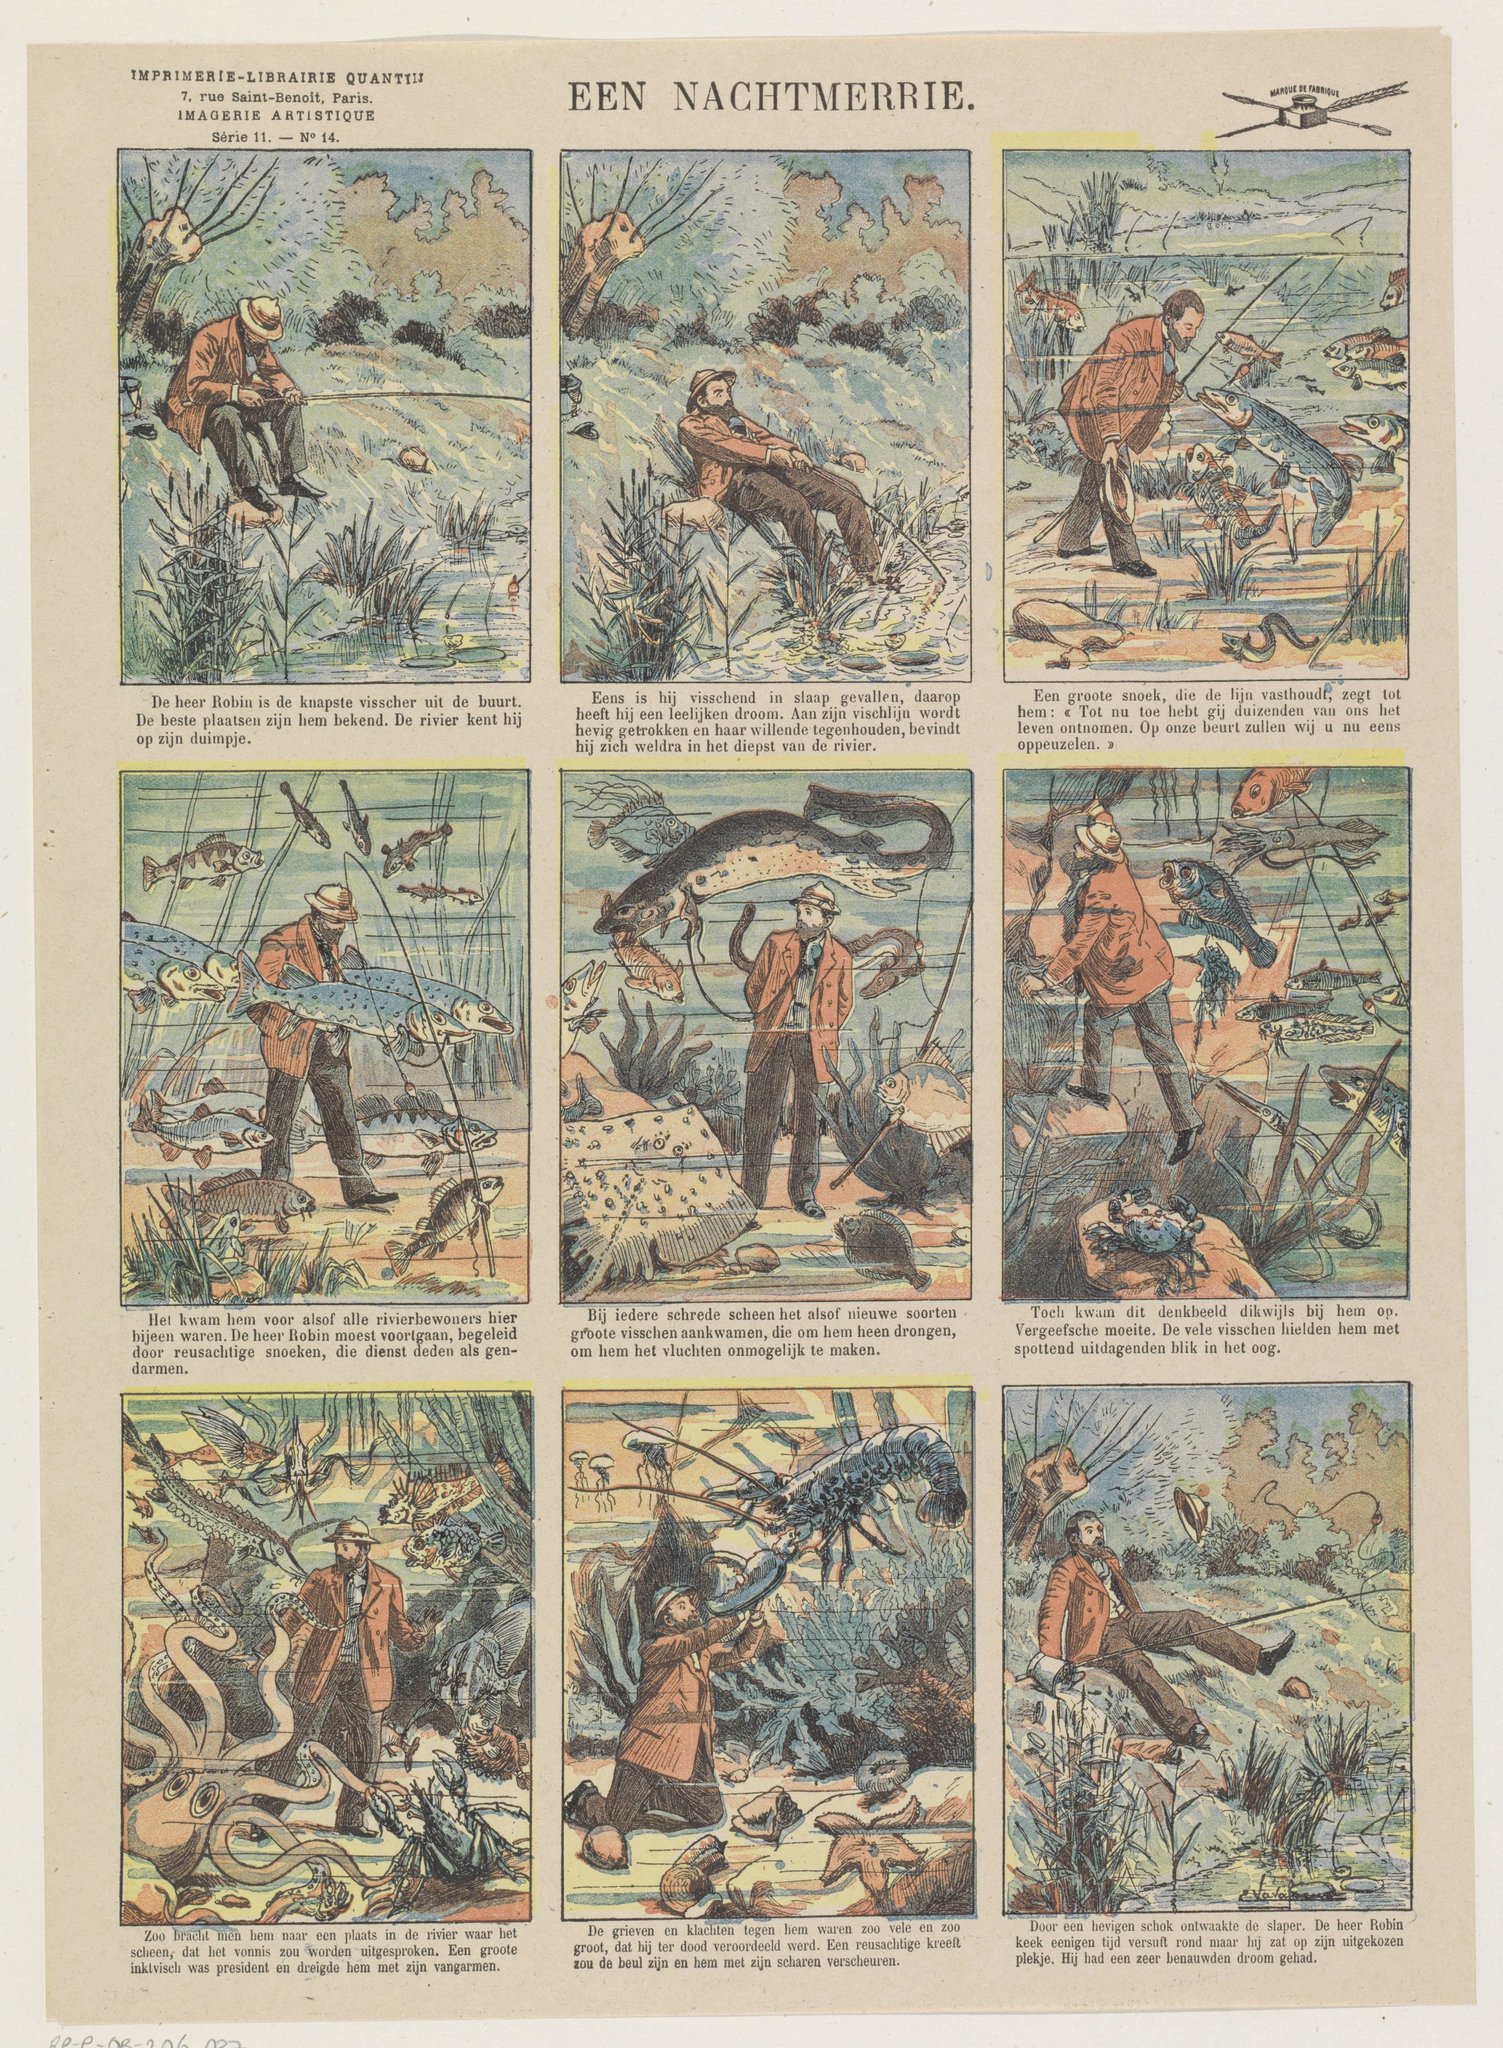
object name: print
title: Een nachtmerrie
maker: albert quantin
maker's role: printer, publisher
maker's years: 1850-1933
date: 1876-1890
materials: paper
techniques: lithograph, letterpress printing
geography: paris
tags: fishes, tales and fairy tales, dream, fisherman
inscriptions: : ‘marque de fabrique / deposée’, collector's mark: Lugt 2760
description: Blad met 9 voorstellingen van een visser die droomt dat hij onder water tussen de vissen en andere zeedieren loopt. Onder elke afbeelding een onderschrift. Genummerd linksboven: Série 11. - No. 14.